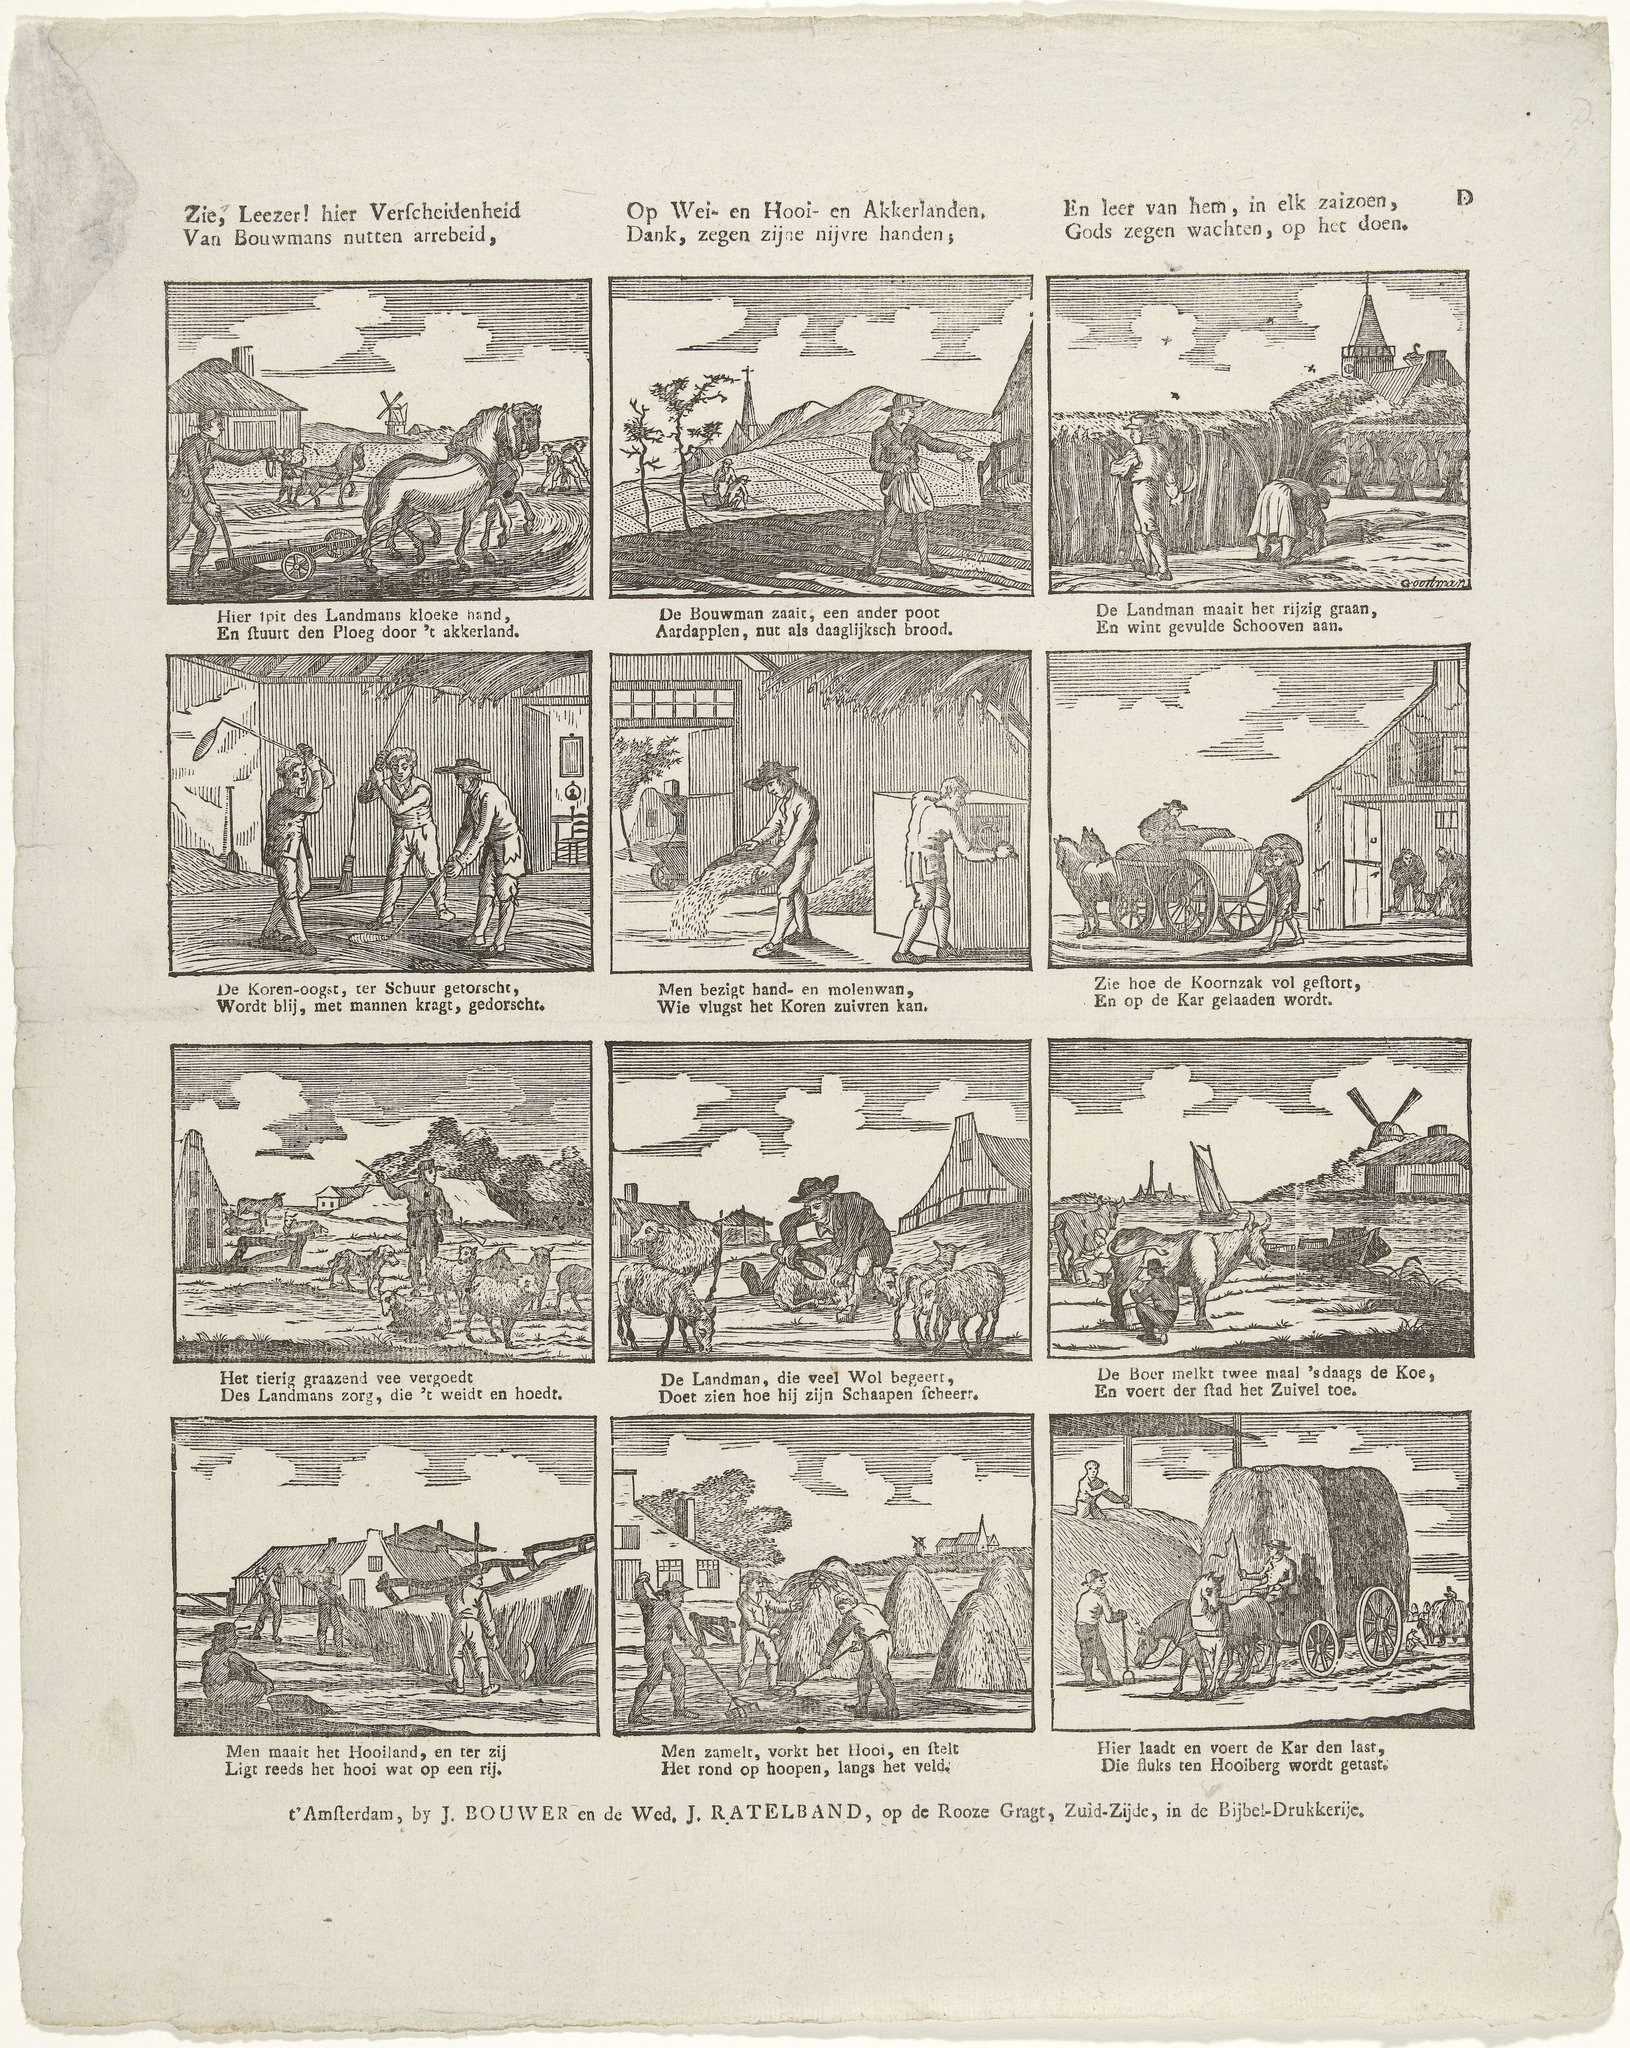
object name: print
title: Zie, leezer! hier verscheidenheid / Van bouwmans nutten arrebeid, (...)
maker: gerrit oortman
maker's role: print maker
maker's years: 1781-1822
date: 1794-1804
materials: paper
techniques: letterpress printing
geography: amsterdam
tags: farmers, agriculture, cattle-breeding, horticulture, flowerculture, etc.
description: Blad met 12 voorstellingen van het werk van de boer in landbouw en veeteelt. Onder elke afbeelding een tweeregelig vers. Genummerd rechtsboven: D.